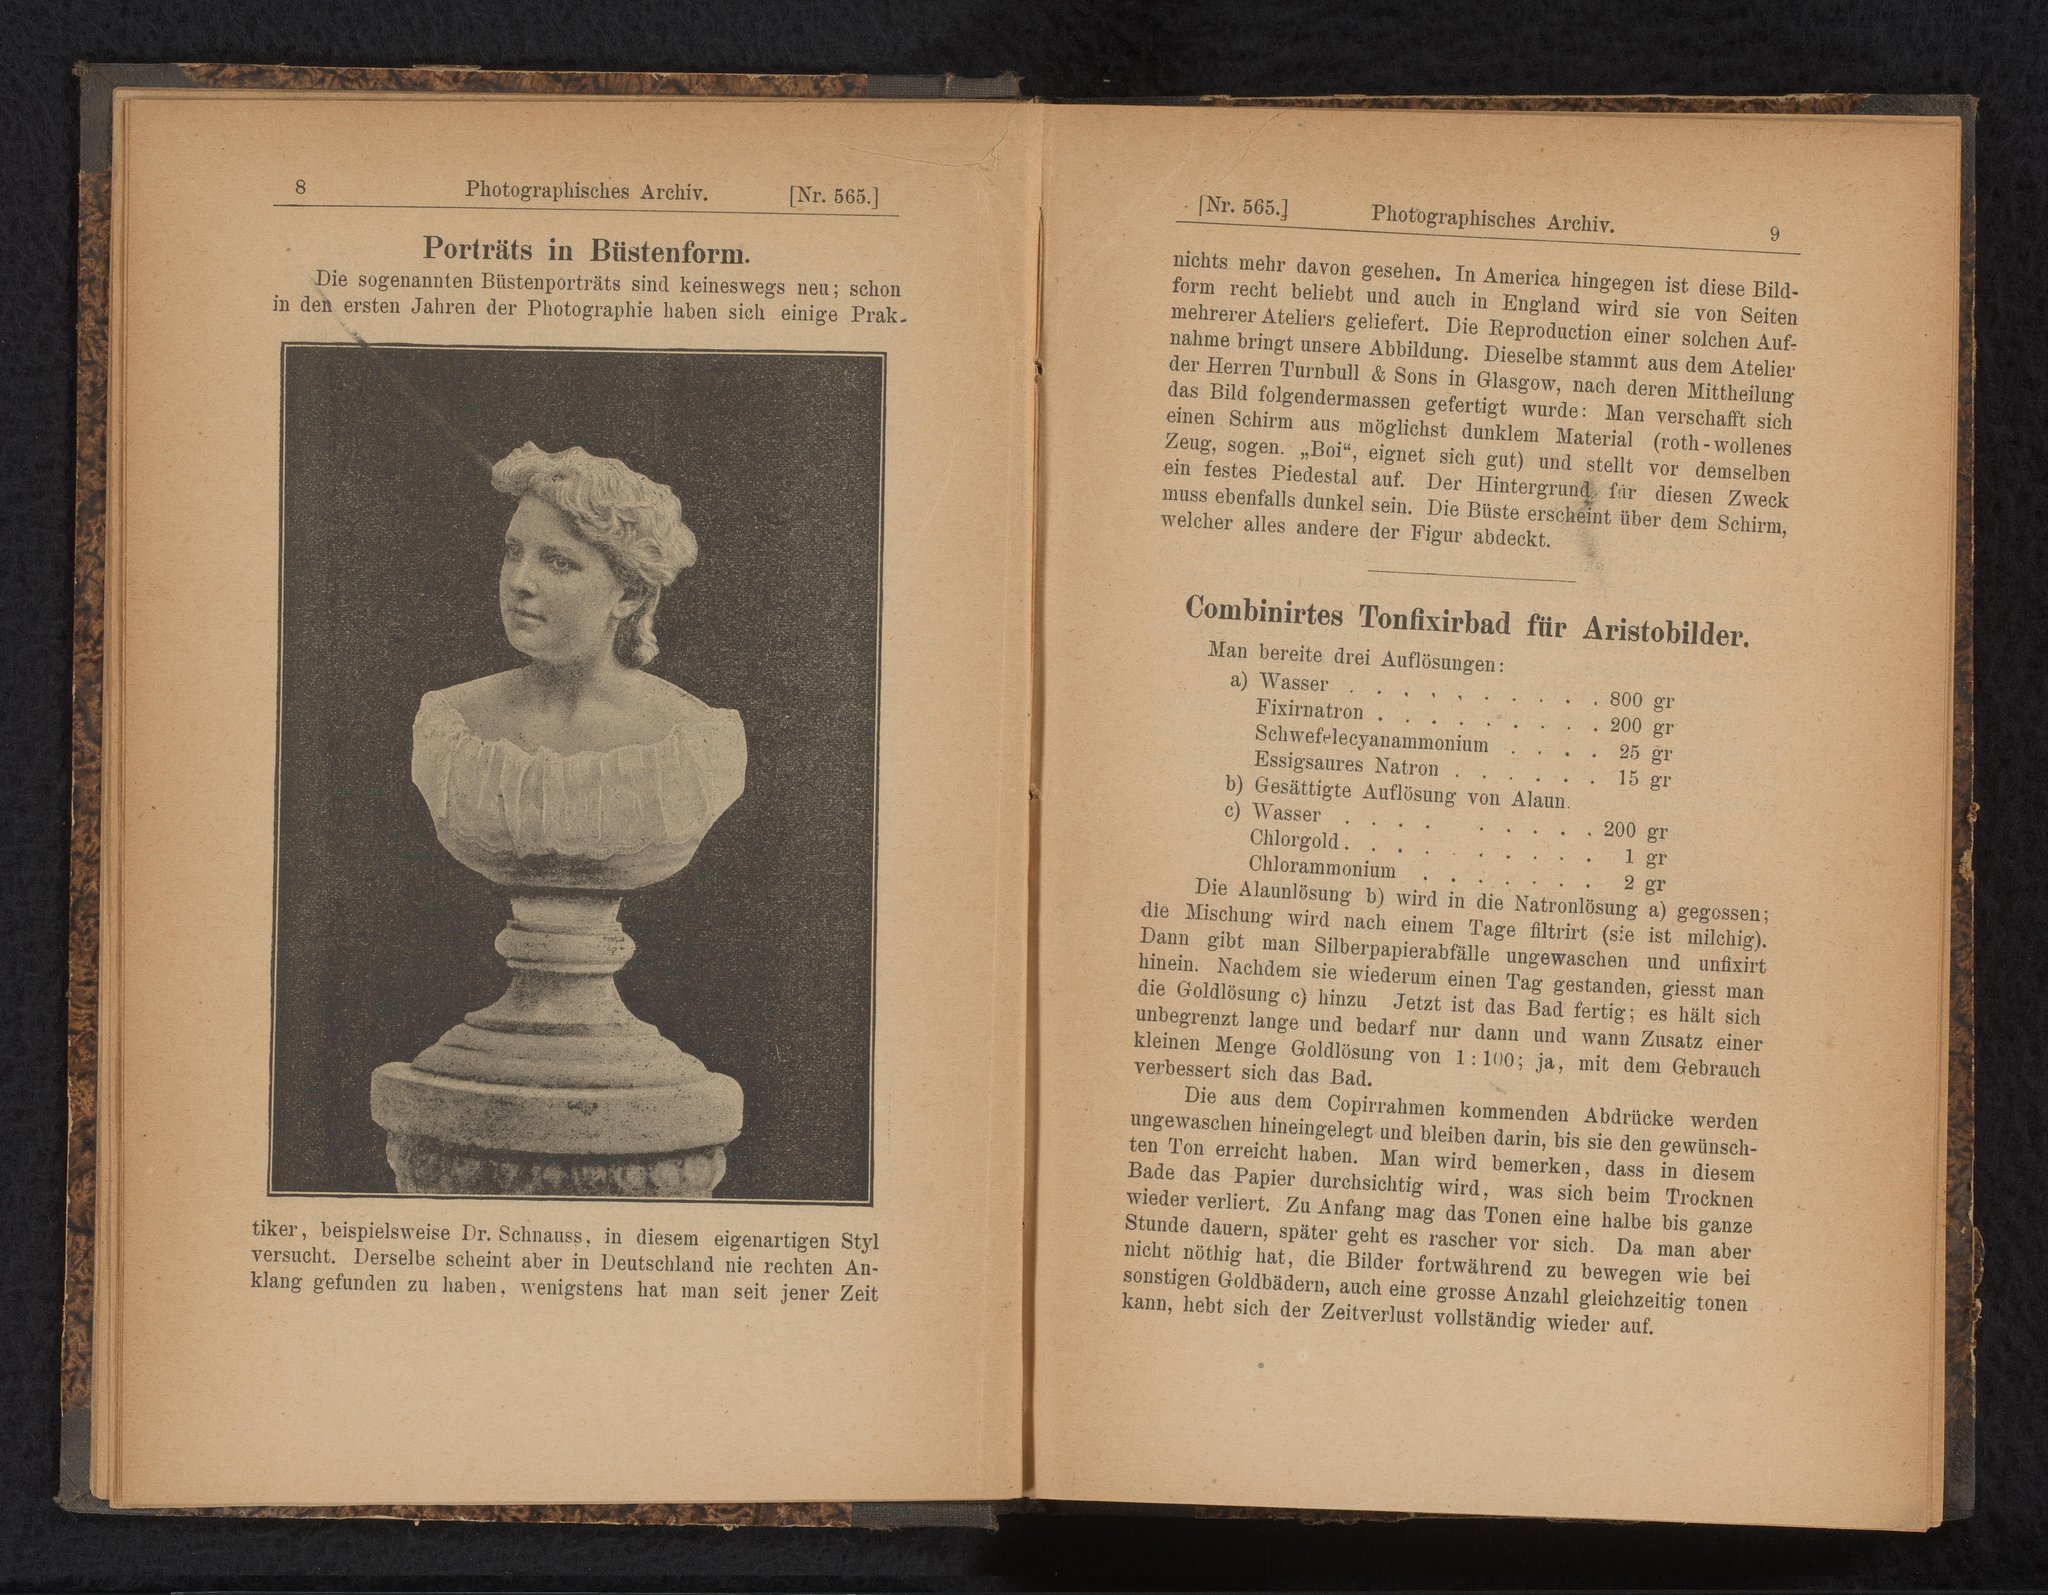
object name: photomechanical print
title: Portret van een onbekende vrouw, gemonteerd als ware het een buste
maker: Anonymous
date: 1882-1887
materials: paper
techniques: autotype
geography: glasgow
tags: historical persons not known by name - bb - woman, piece of sculpture, reproduction of a piece of sculpture